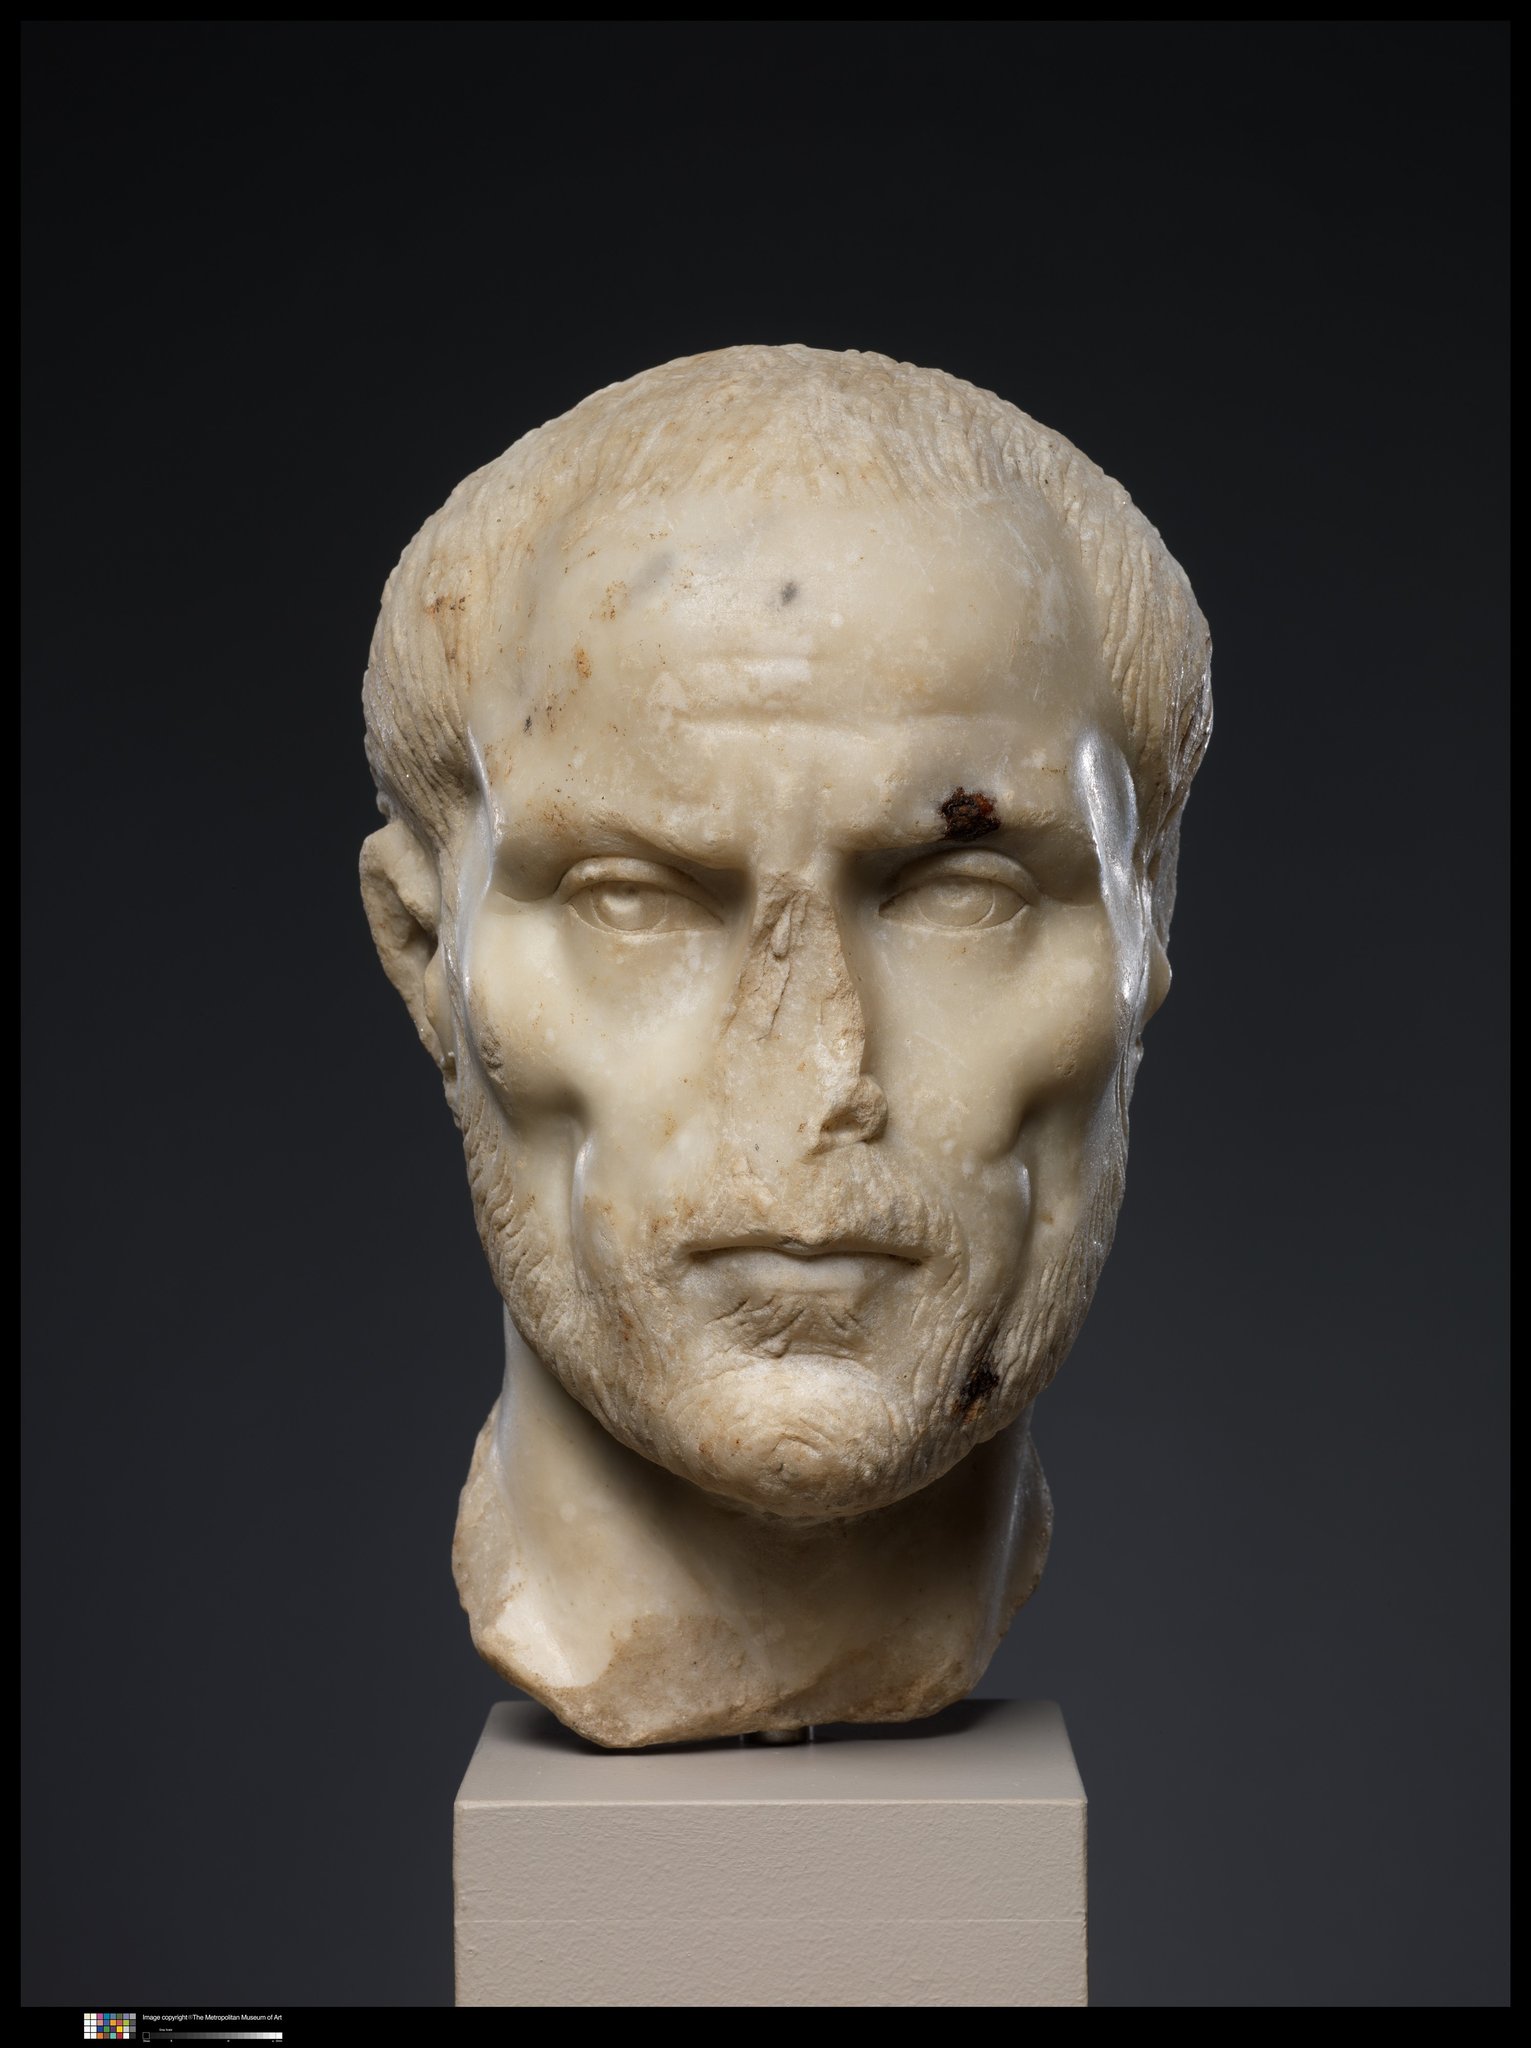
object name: portrait head of a man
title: Marble portrait of a man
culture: roman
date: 201-250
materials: marble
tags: heads,men,portraits